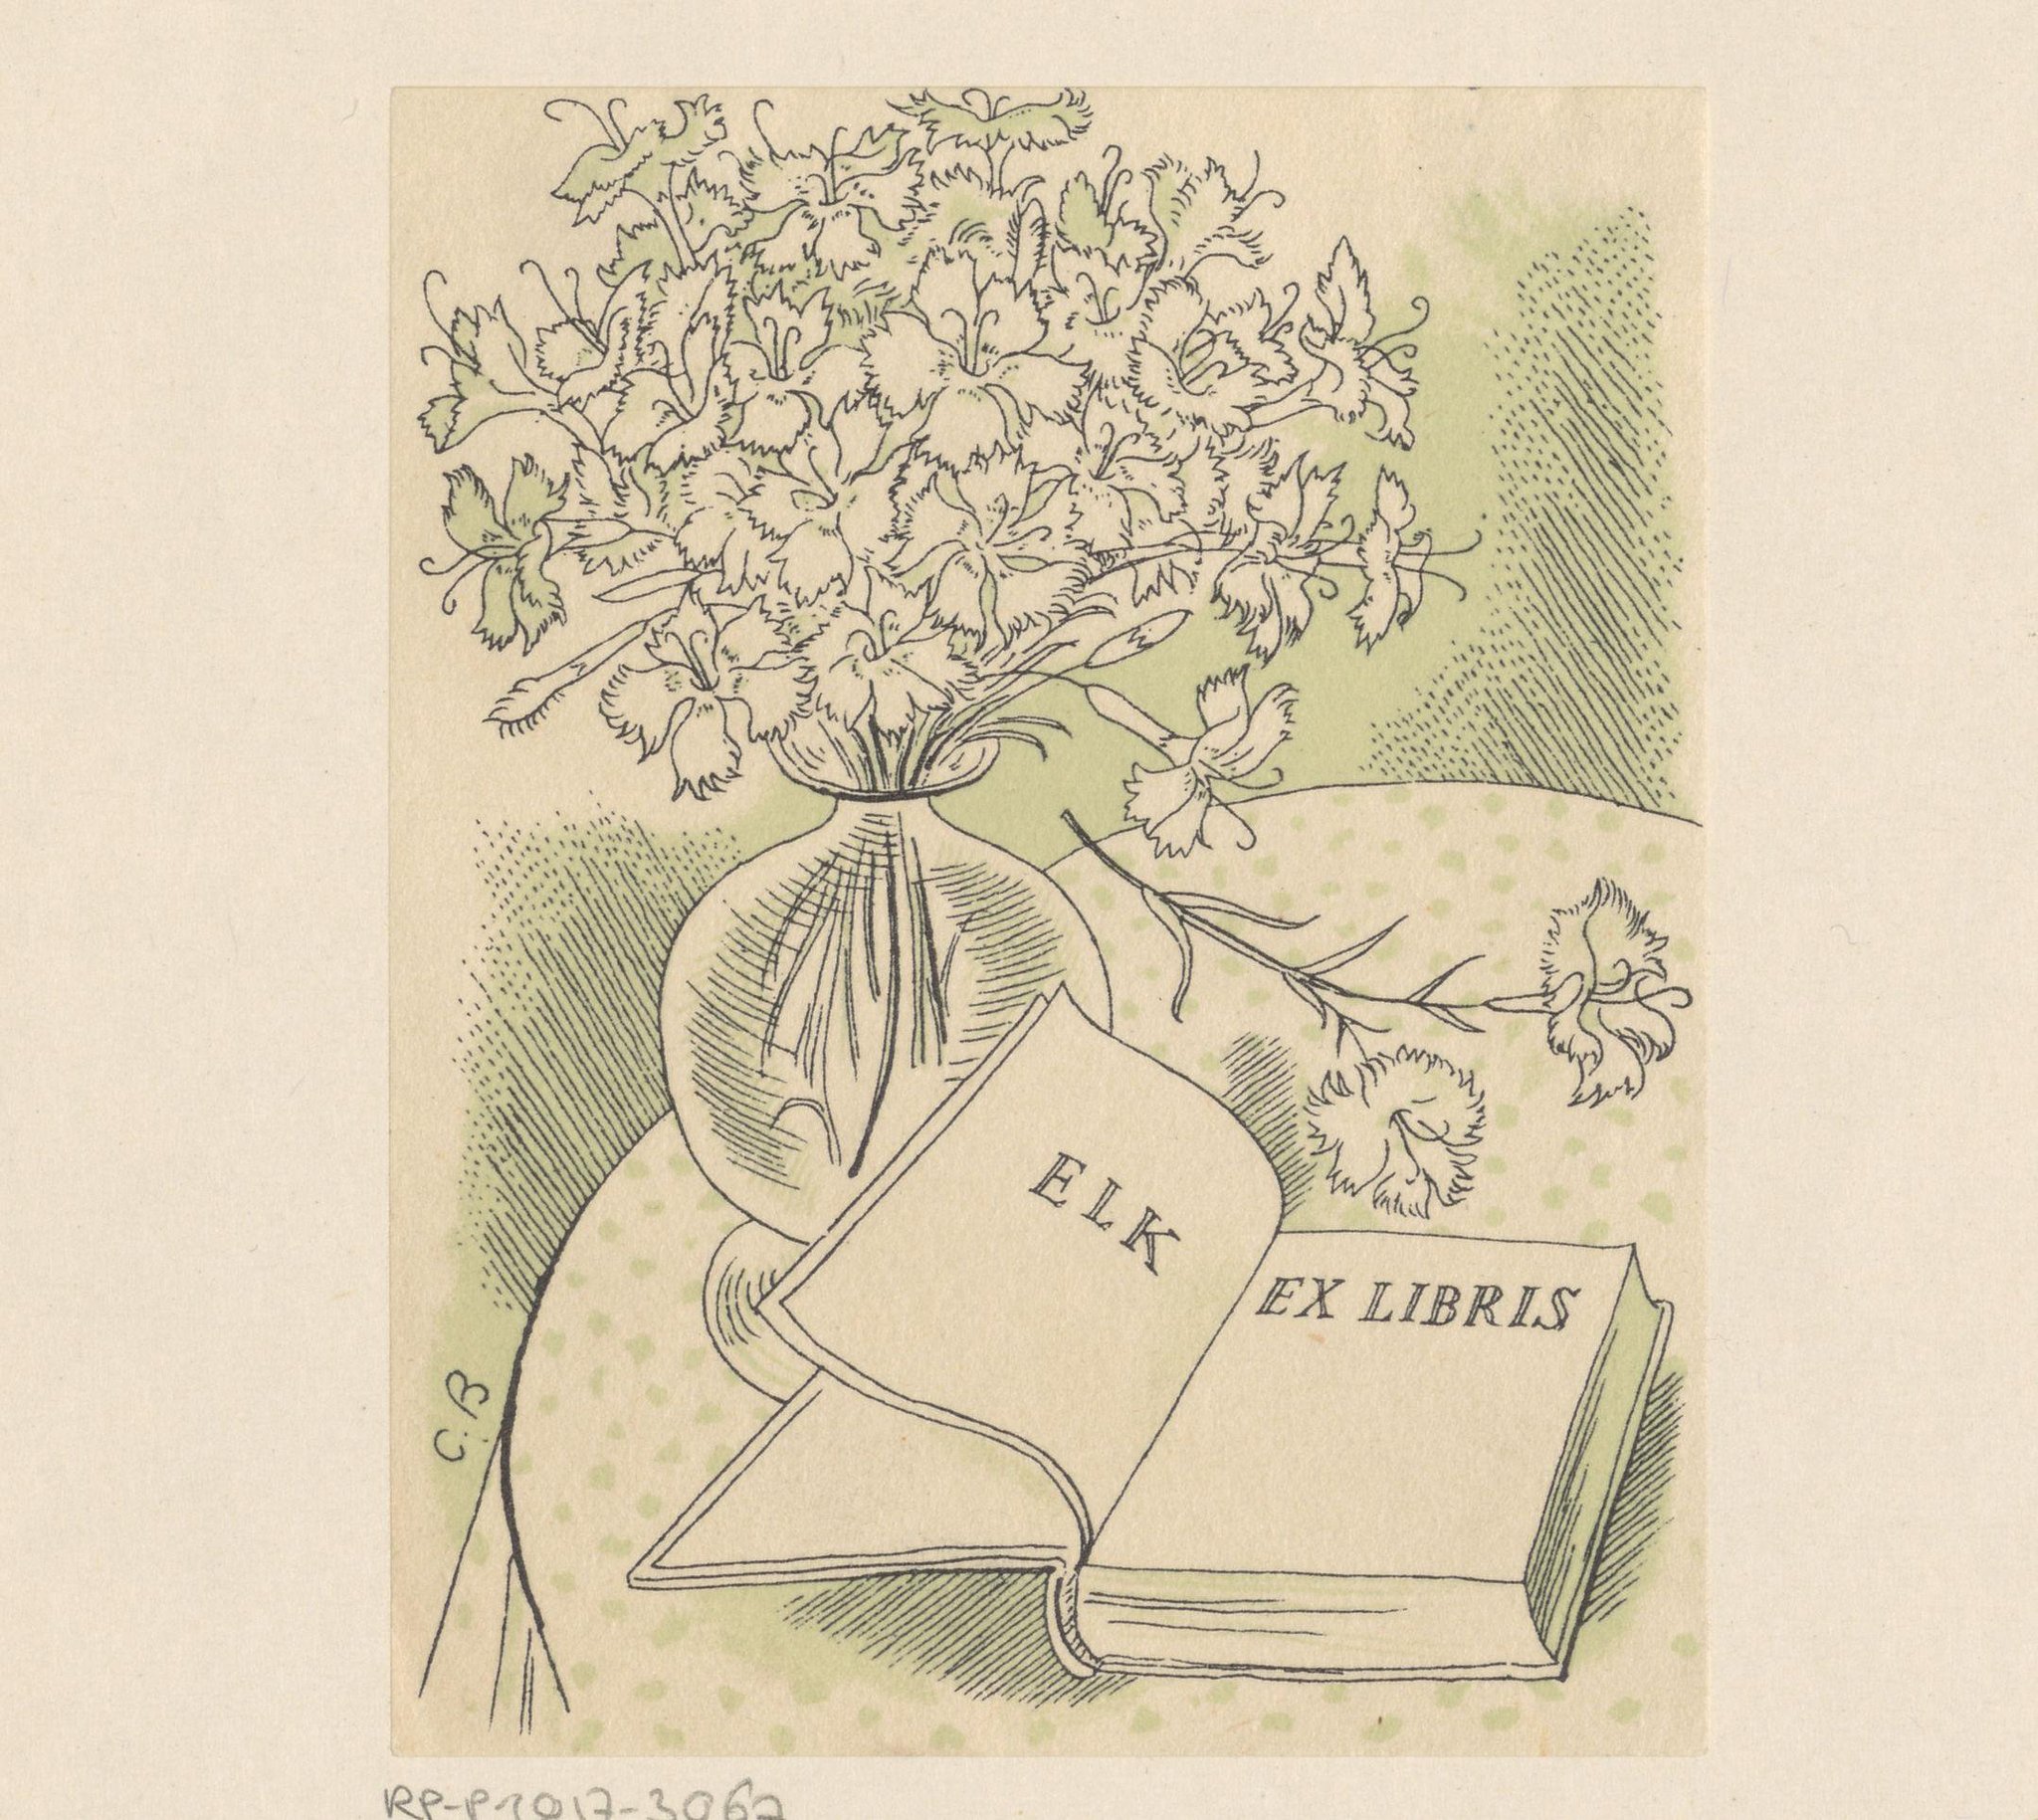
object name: bookplate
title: Ex libris van E.L.K.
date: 1900-1999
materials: paper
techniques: printing block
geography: sweden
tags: book, flowers in a vase